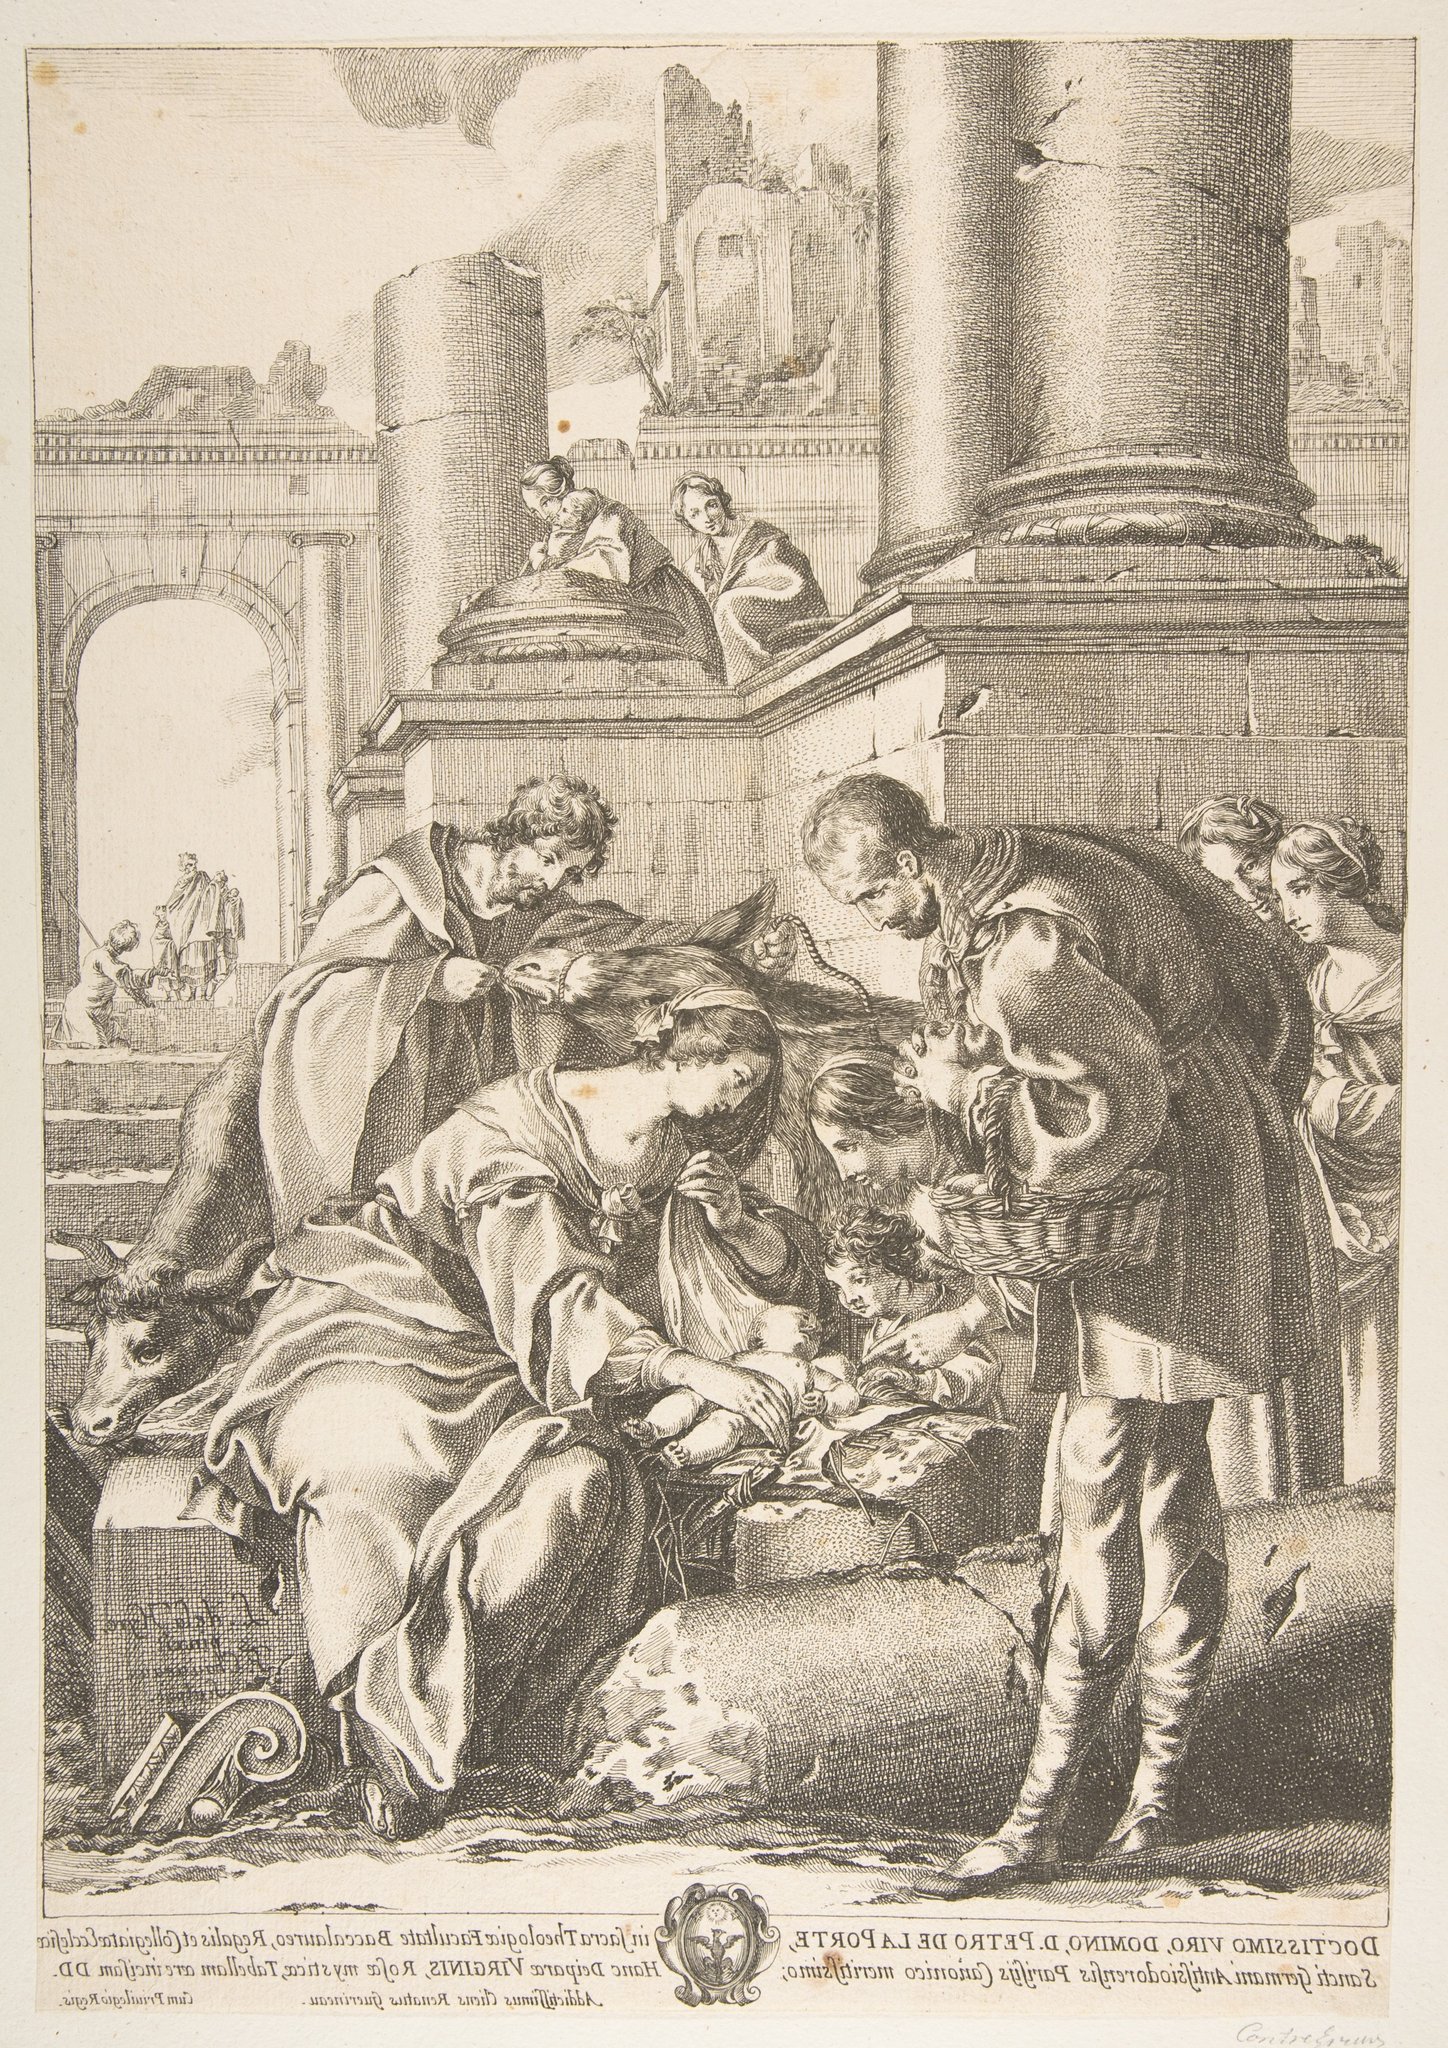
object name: print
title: Adoration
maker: françois chauveau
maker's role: artist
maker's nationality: french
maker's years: 1613-1676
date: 1613-1676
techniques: printmaking, etching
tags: christ,virgin mary,adoration of the magi